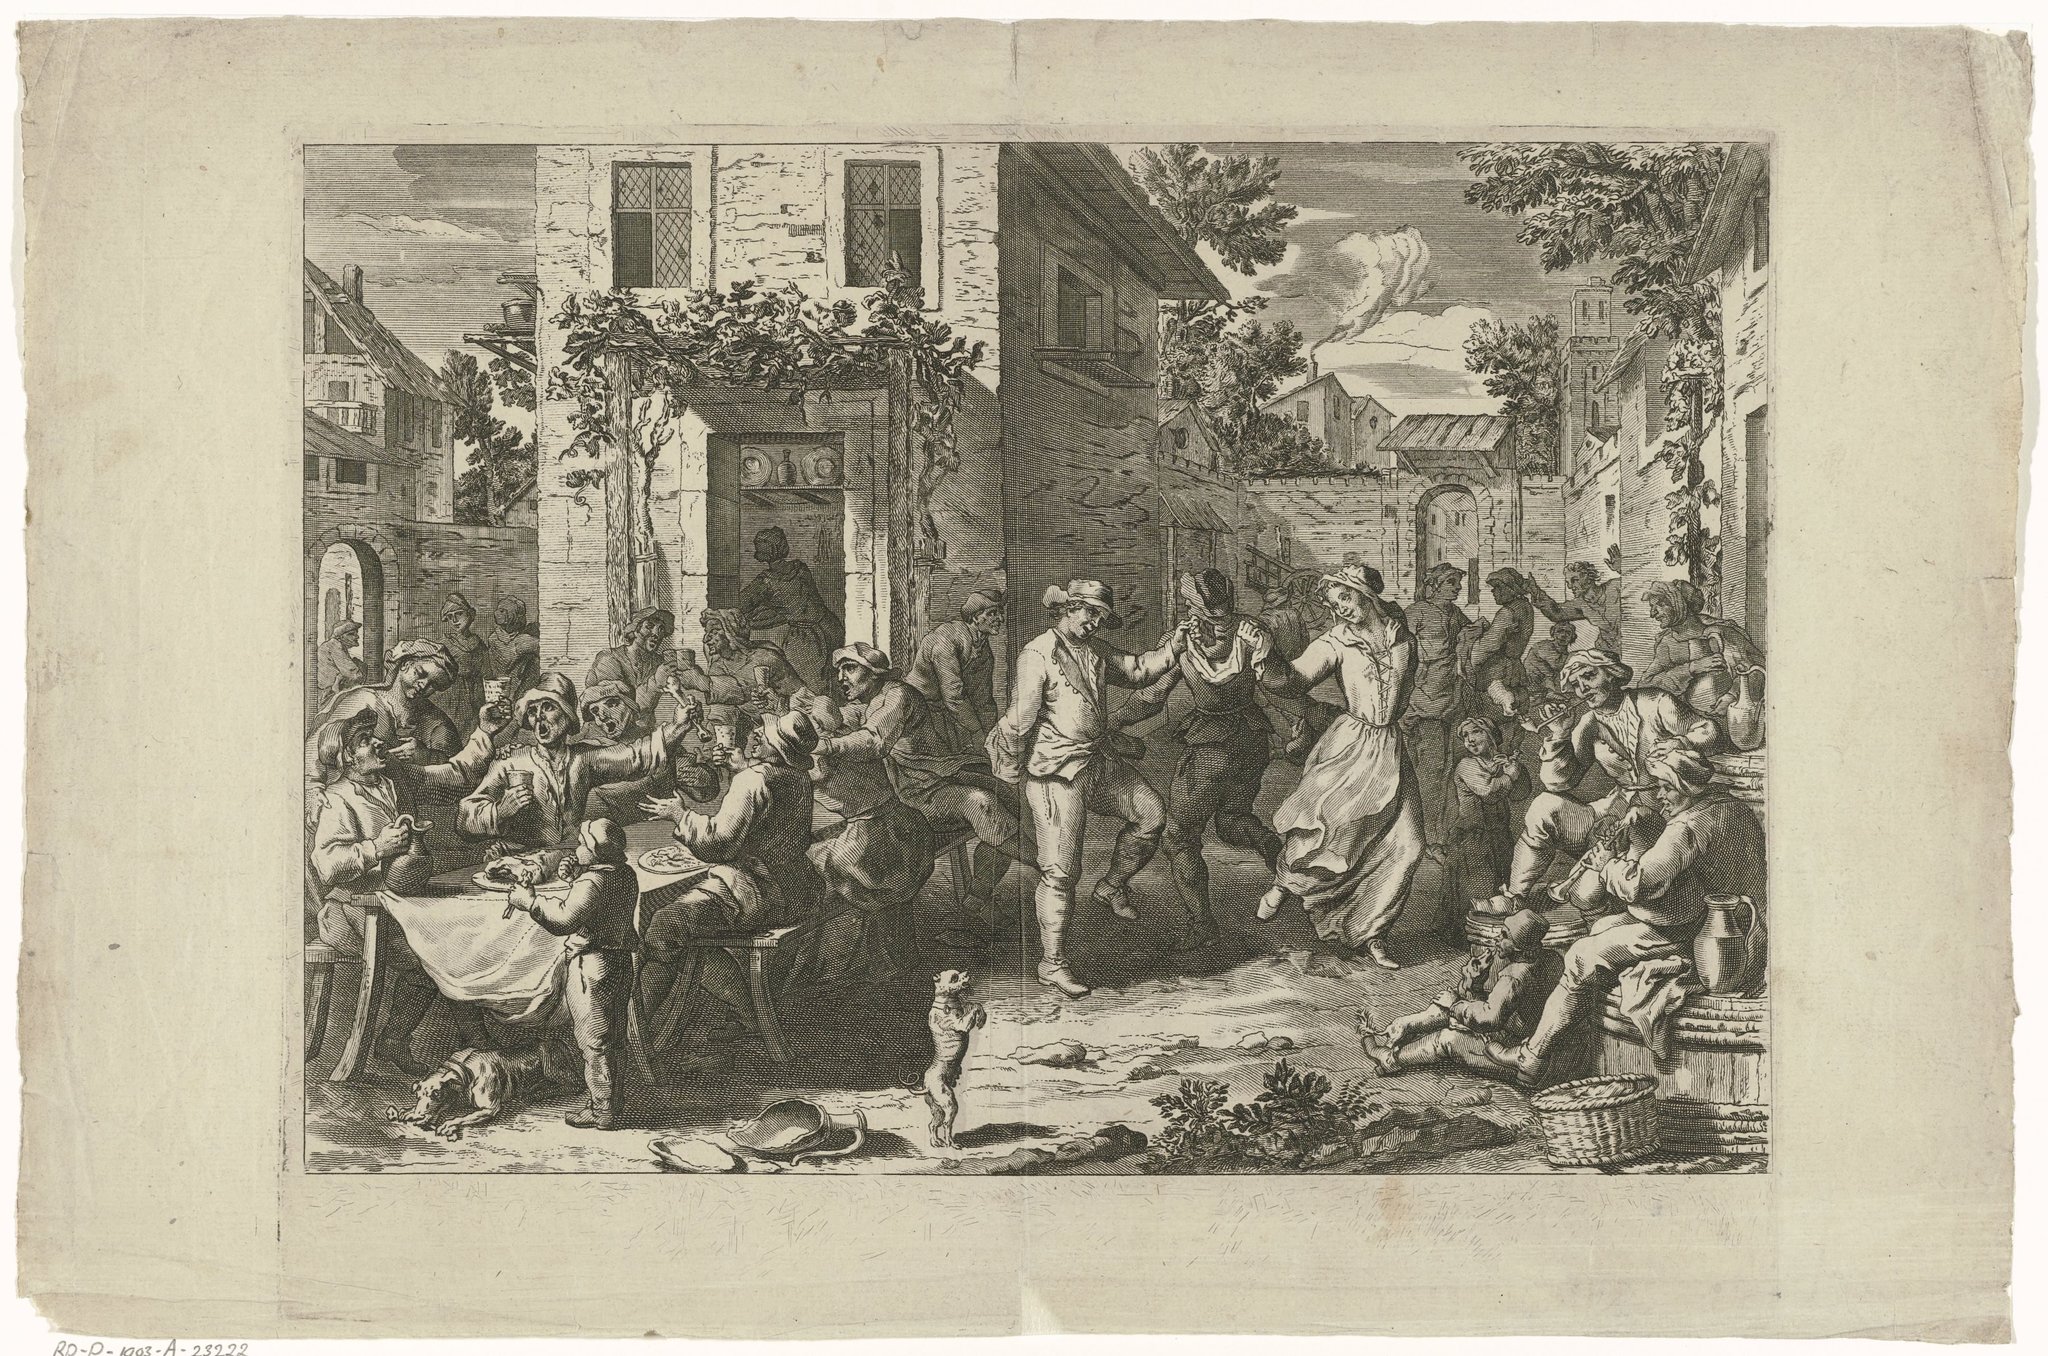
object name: print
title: Buitenpartij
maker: Anonymous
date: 1650-1750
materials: paper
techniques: etching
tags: one pair dancing; man and woman dancing as a couple, drinking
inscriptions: collector's mark: Lugt 2228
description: Mensen vieren buiten feest. Links een lange tafel met etende en drinkende mensen. Rechts een dansend paar en een dansend hondje. Geheel rechts muzikanten.